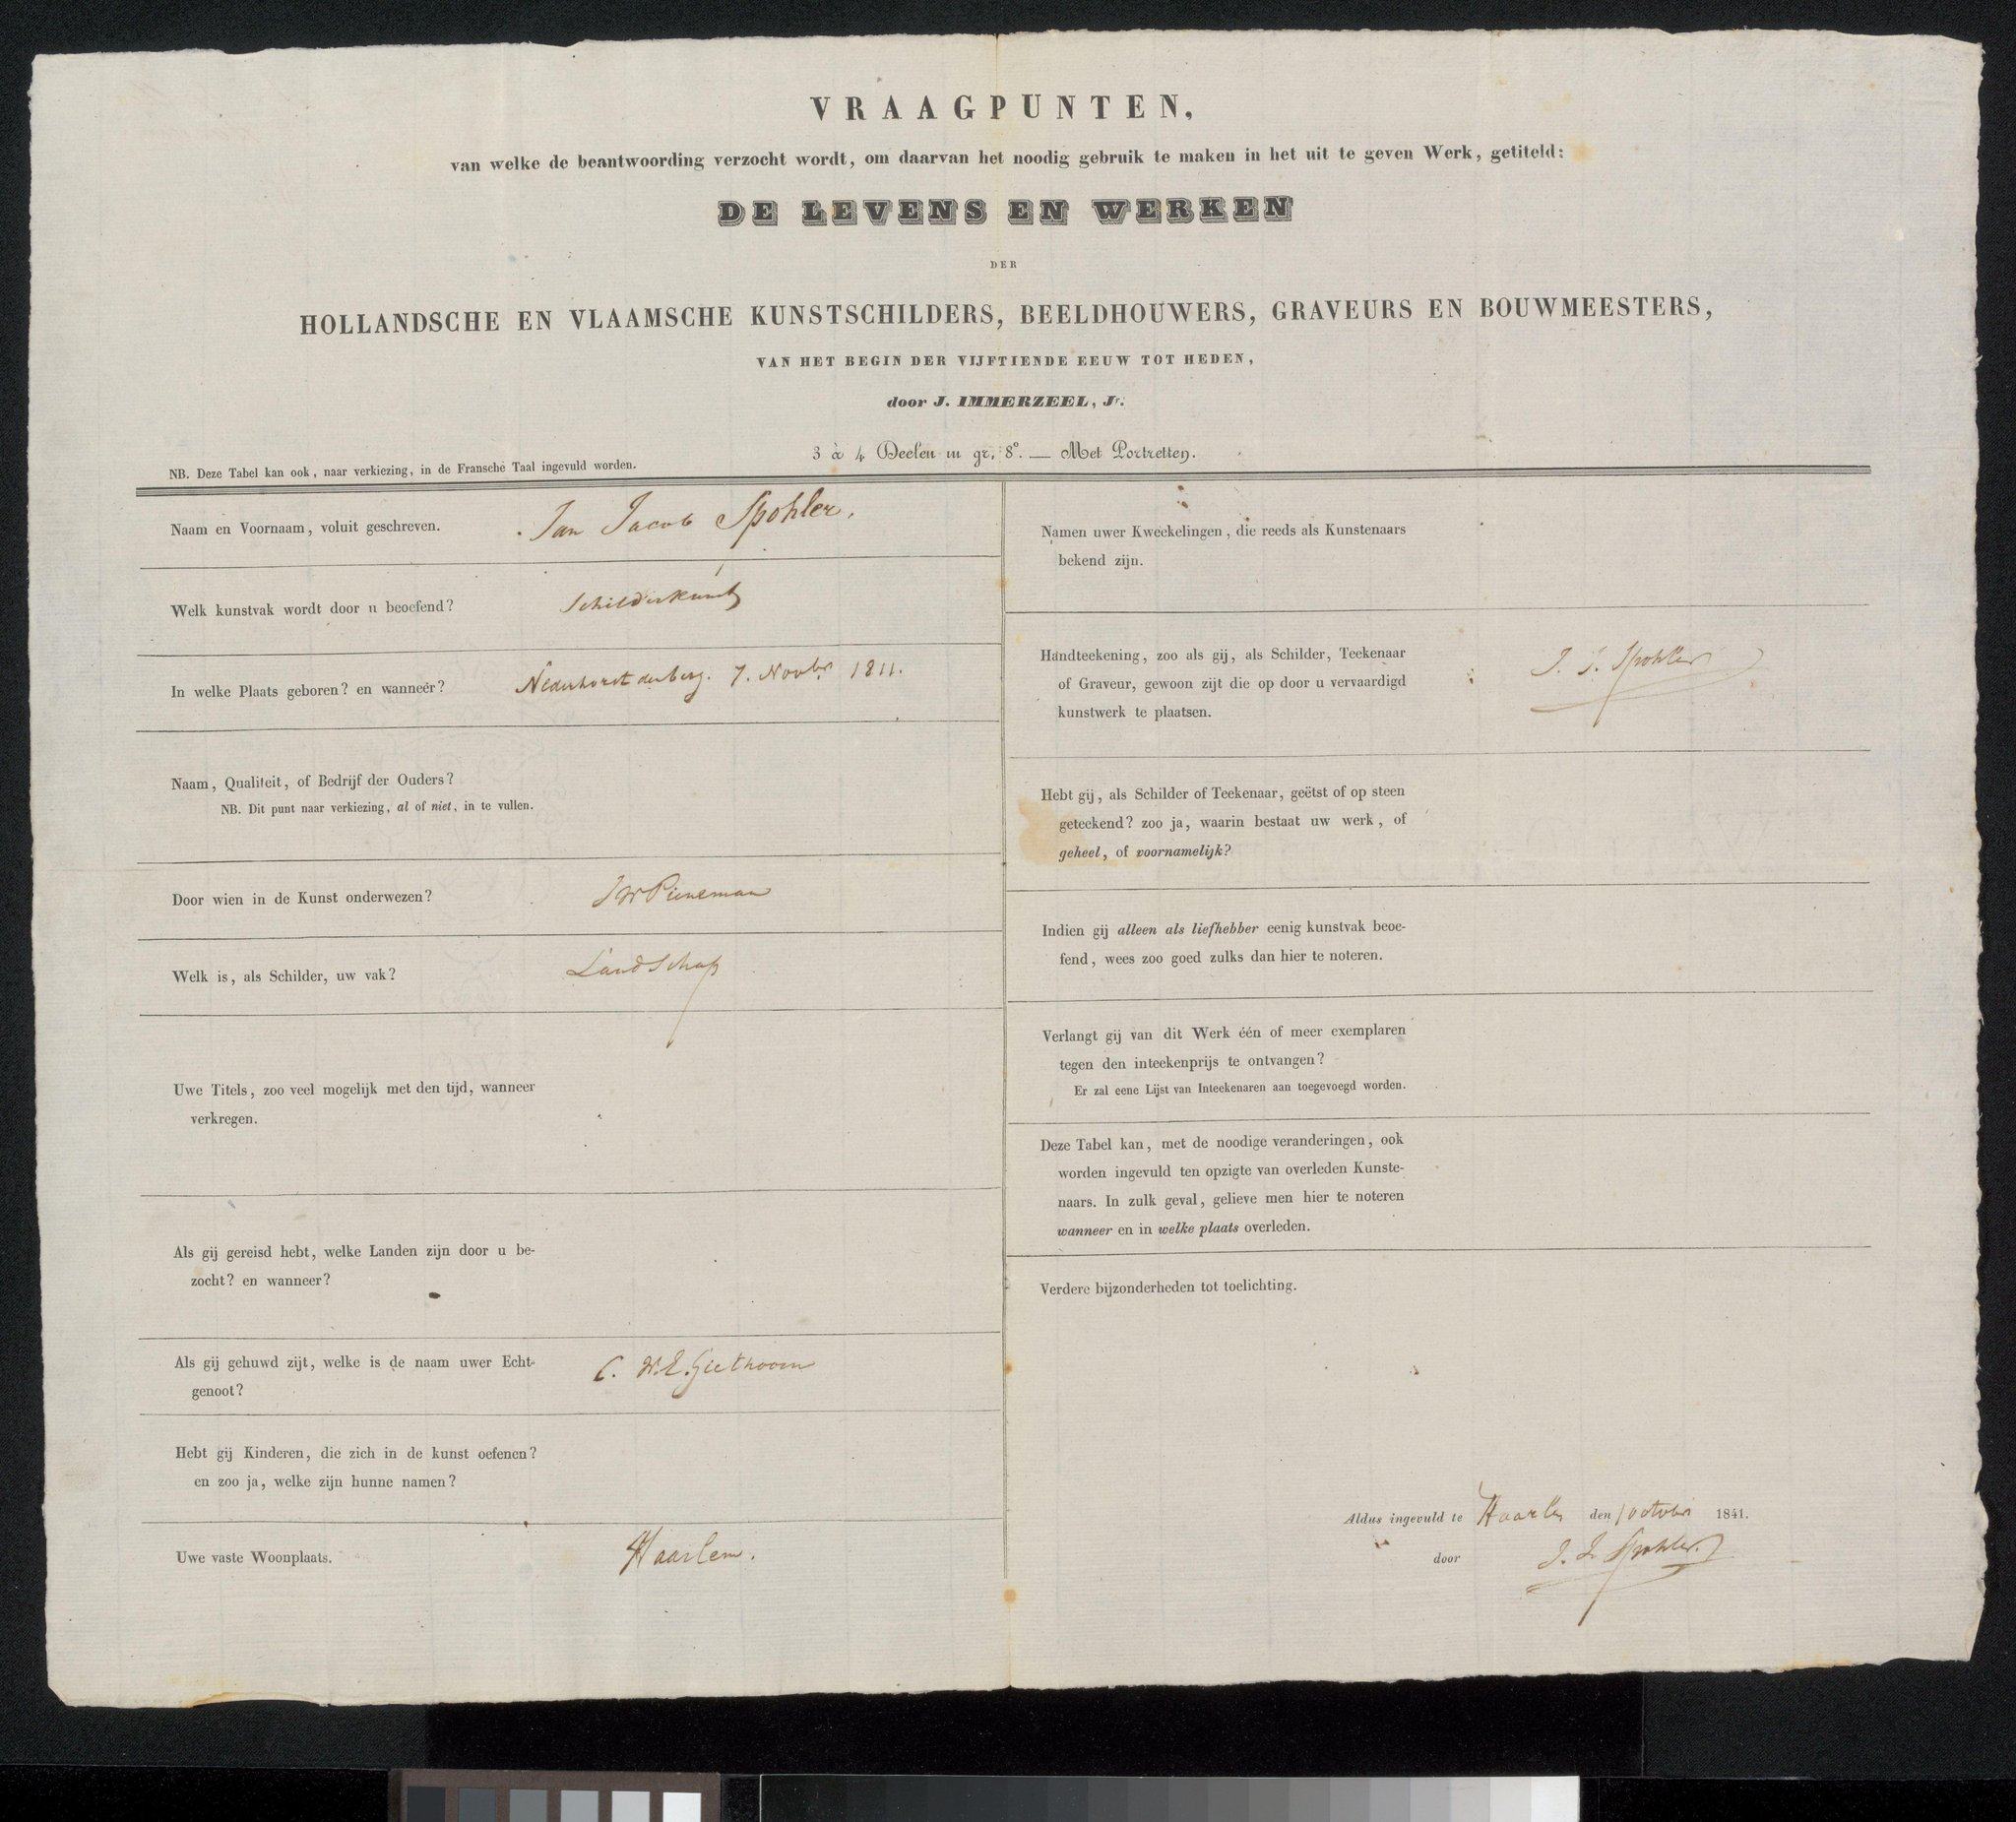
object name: manuscript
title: Enquêteformulier ingevuld door Jan Jacob Spohler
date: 1841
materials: ink, paper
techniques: pen, printing, writing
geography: haarlem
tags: nederhorst den berg, amsterdam, painter, jan jacob spohler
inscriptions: watermark, inscription: ‘Vraagpunten,/ van welke de beantwoording verzocht wordt, om daarvan het noodig gebruik te maken in het uit te geven Werk, getiteld: De levens en werken/ der Hollandsche en Vlaamsche kunstschilders, beeldhouwers,/ graveurs en bouwmeesters, van het begin der vijftiende eeuw tot heden/ door J. Immerzeel, Jr.’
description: Opgenomen in: Immerzeel, J. Jr., De levens en werken der Hollandsche en Vlaamsche kunstschilders, beeldhouwers, graveurs en bouwmeesters, van het begin der vijftiende eeuw tot heden, Amsterdam: J.C. van Kesteren, 1842-1843.